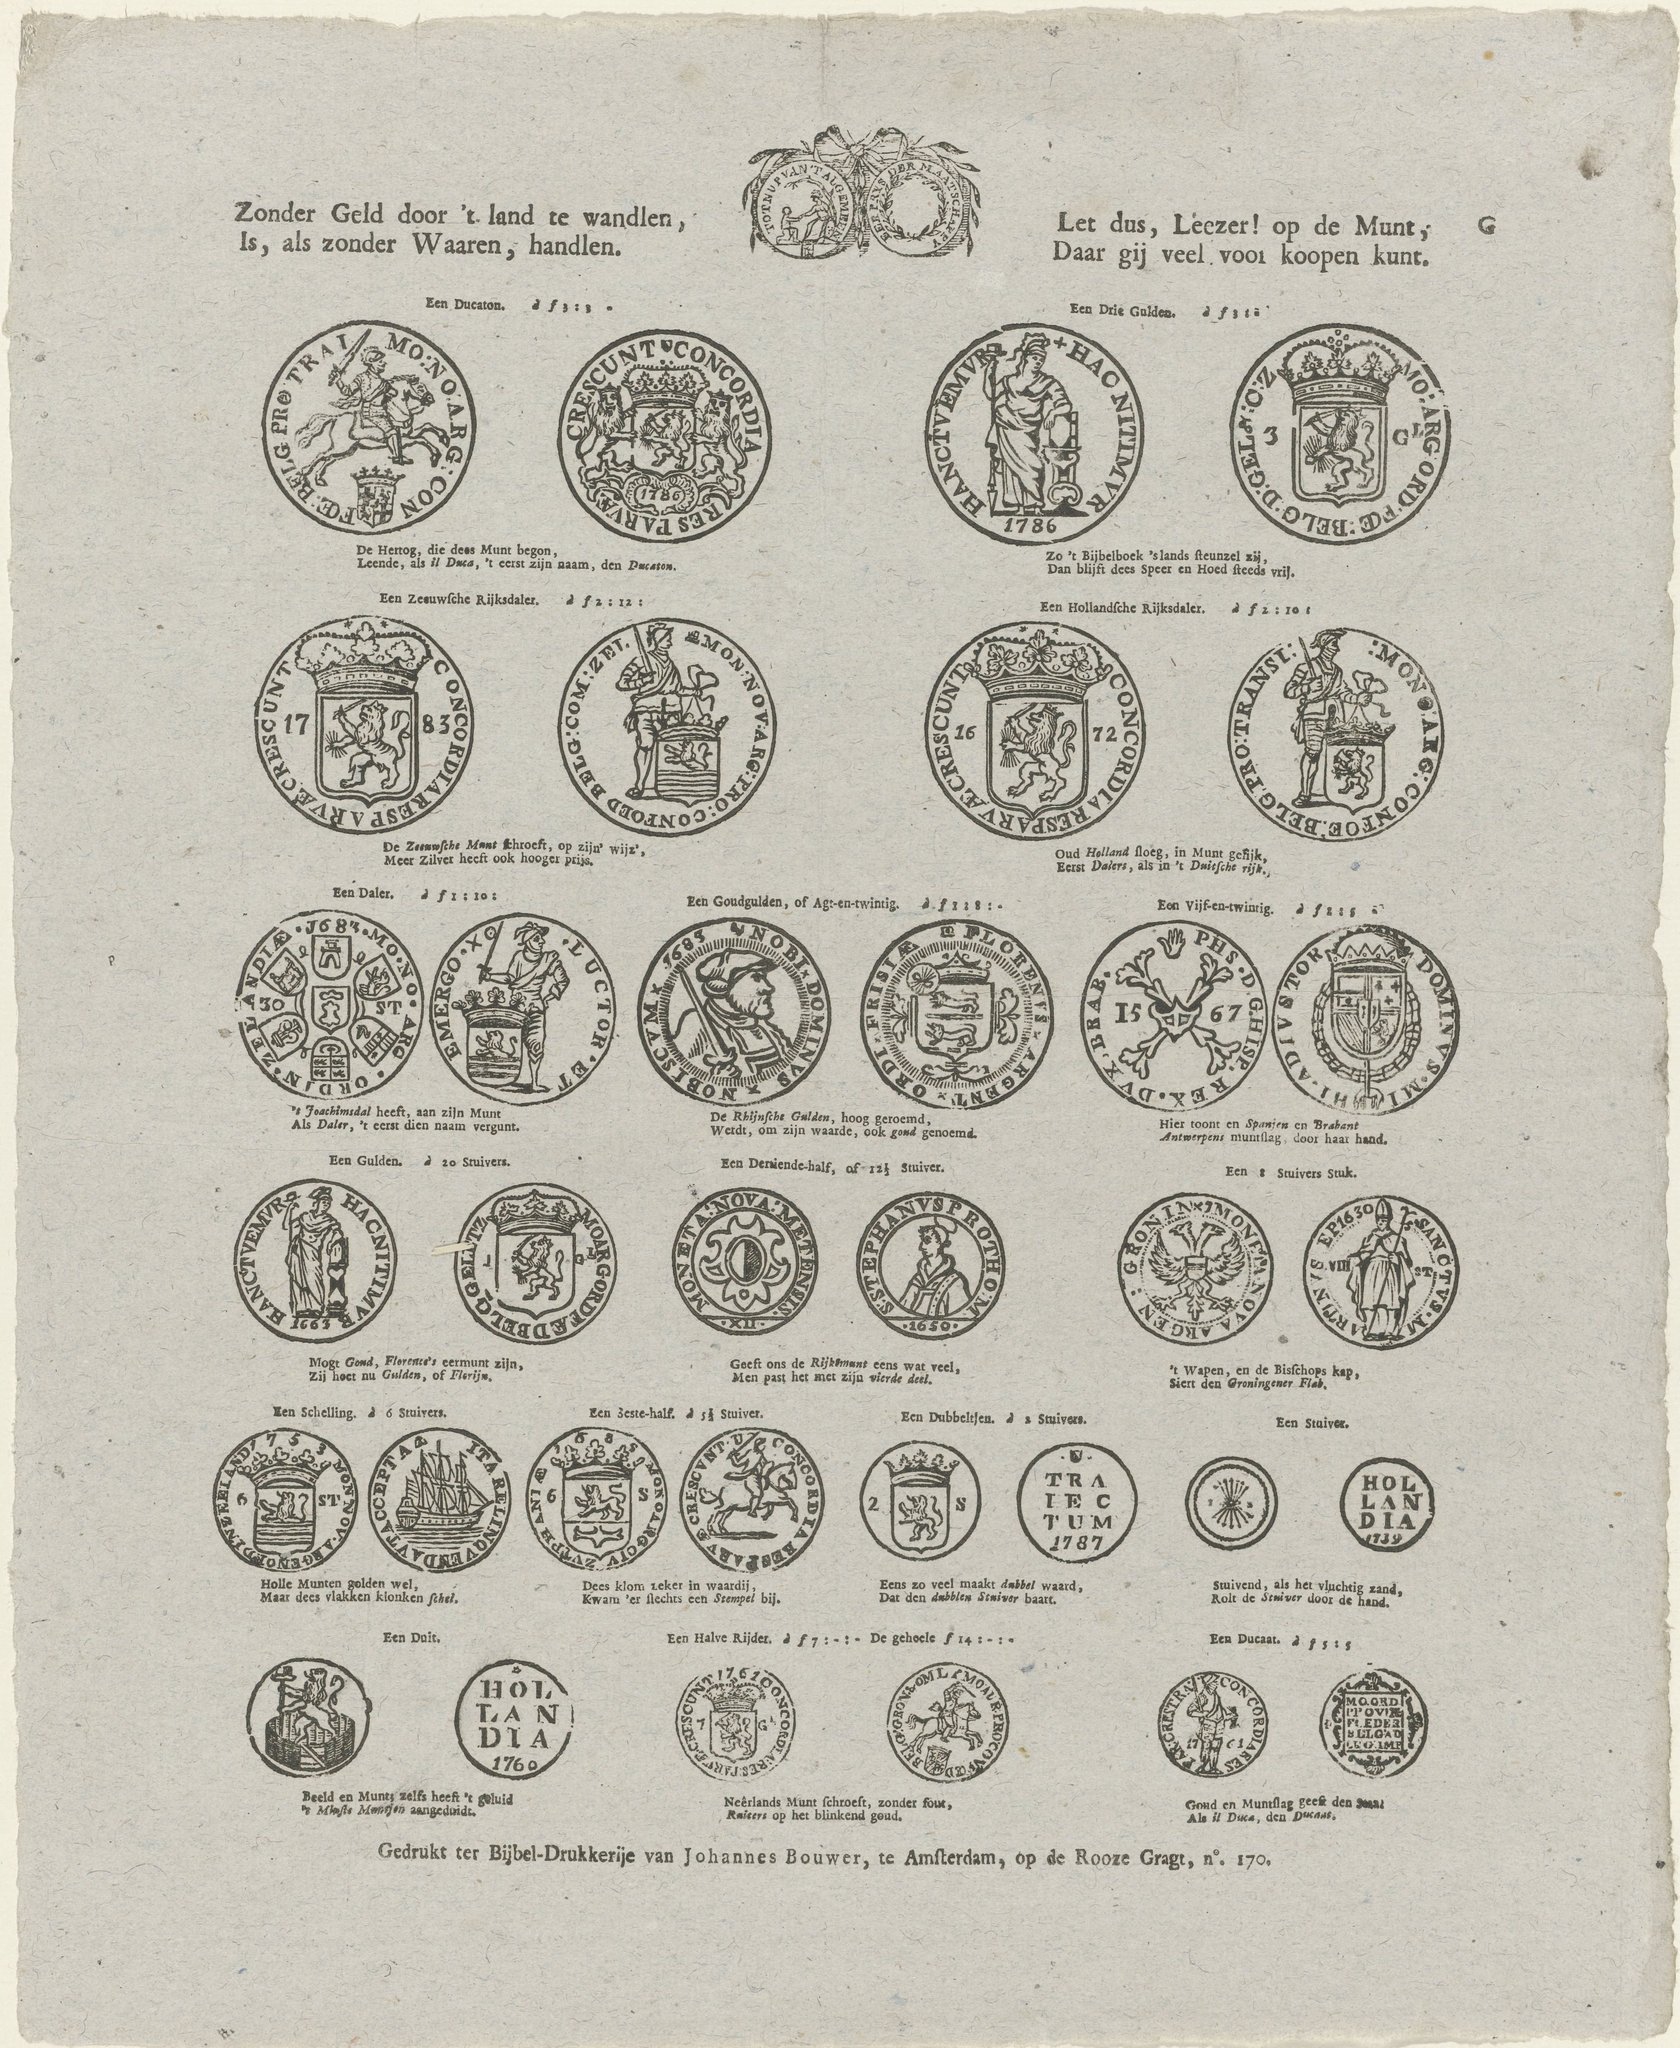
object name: print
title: Zonder geld door 't land te wandlen, / Is als zonder waaren, handlen. / Let dus, leezer! op de munt, / Daar gij veel voor koopen kunt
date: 1805-1808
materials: paper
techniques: letterpress printing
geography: netherlands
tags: coin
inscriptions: collector's mark: Lugt 2760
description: Blad met 17 voorstellingen van oude Nederlandse munten, voor- en keerzijde. Boven elke voorstelling de naam en waarde van de munt, eronder een tweeregelig vers. Midden boven het zegel van de Maatschappij tot Nut van 't Algemeen. Genummerd rechtsboven: G.